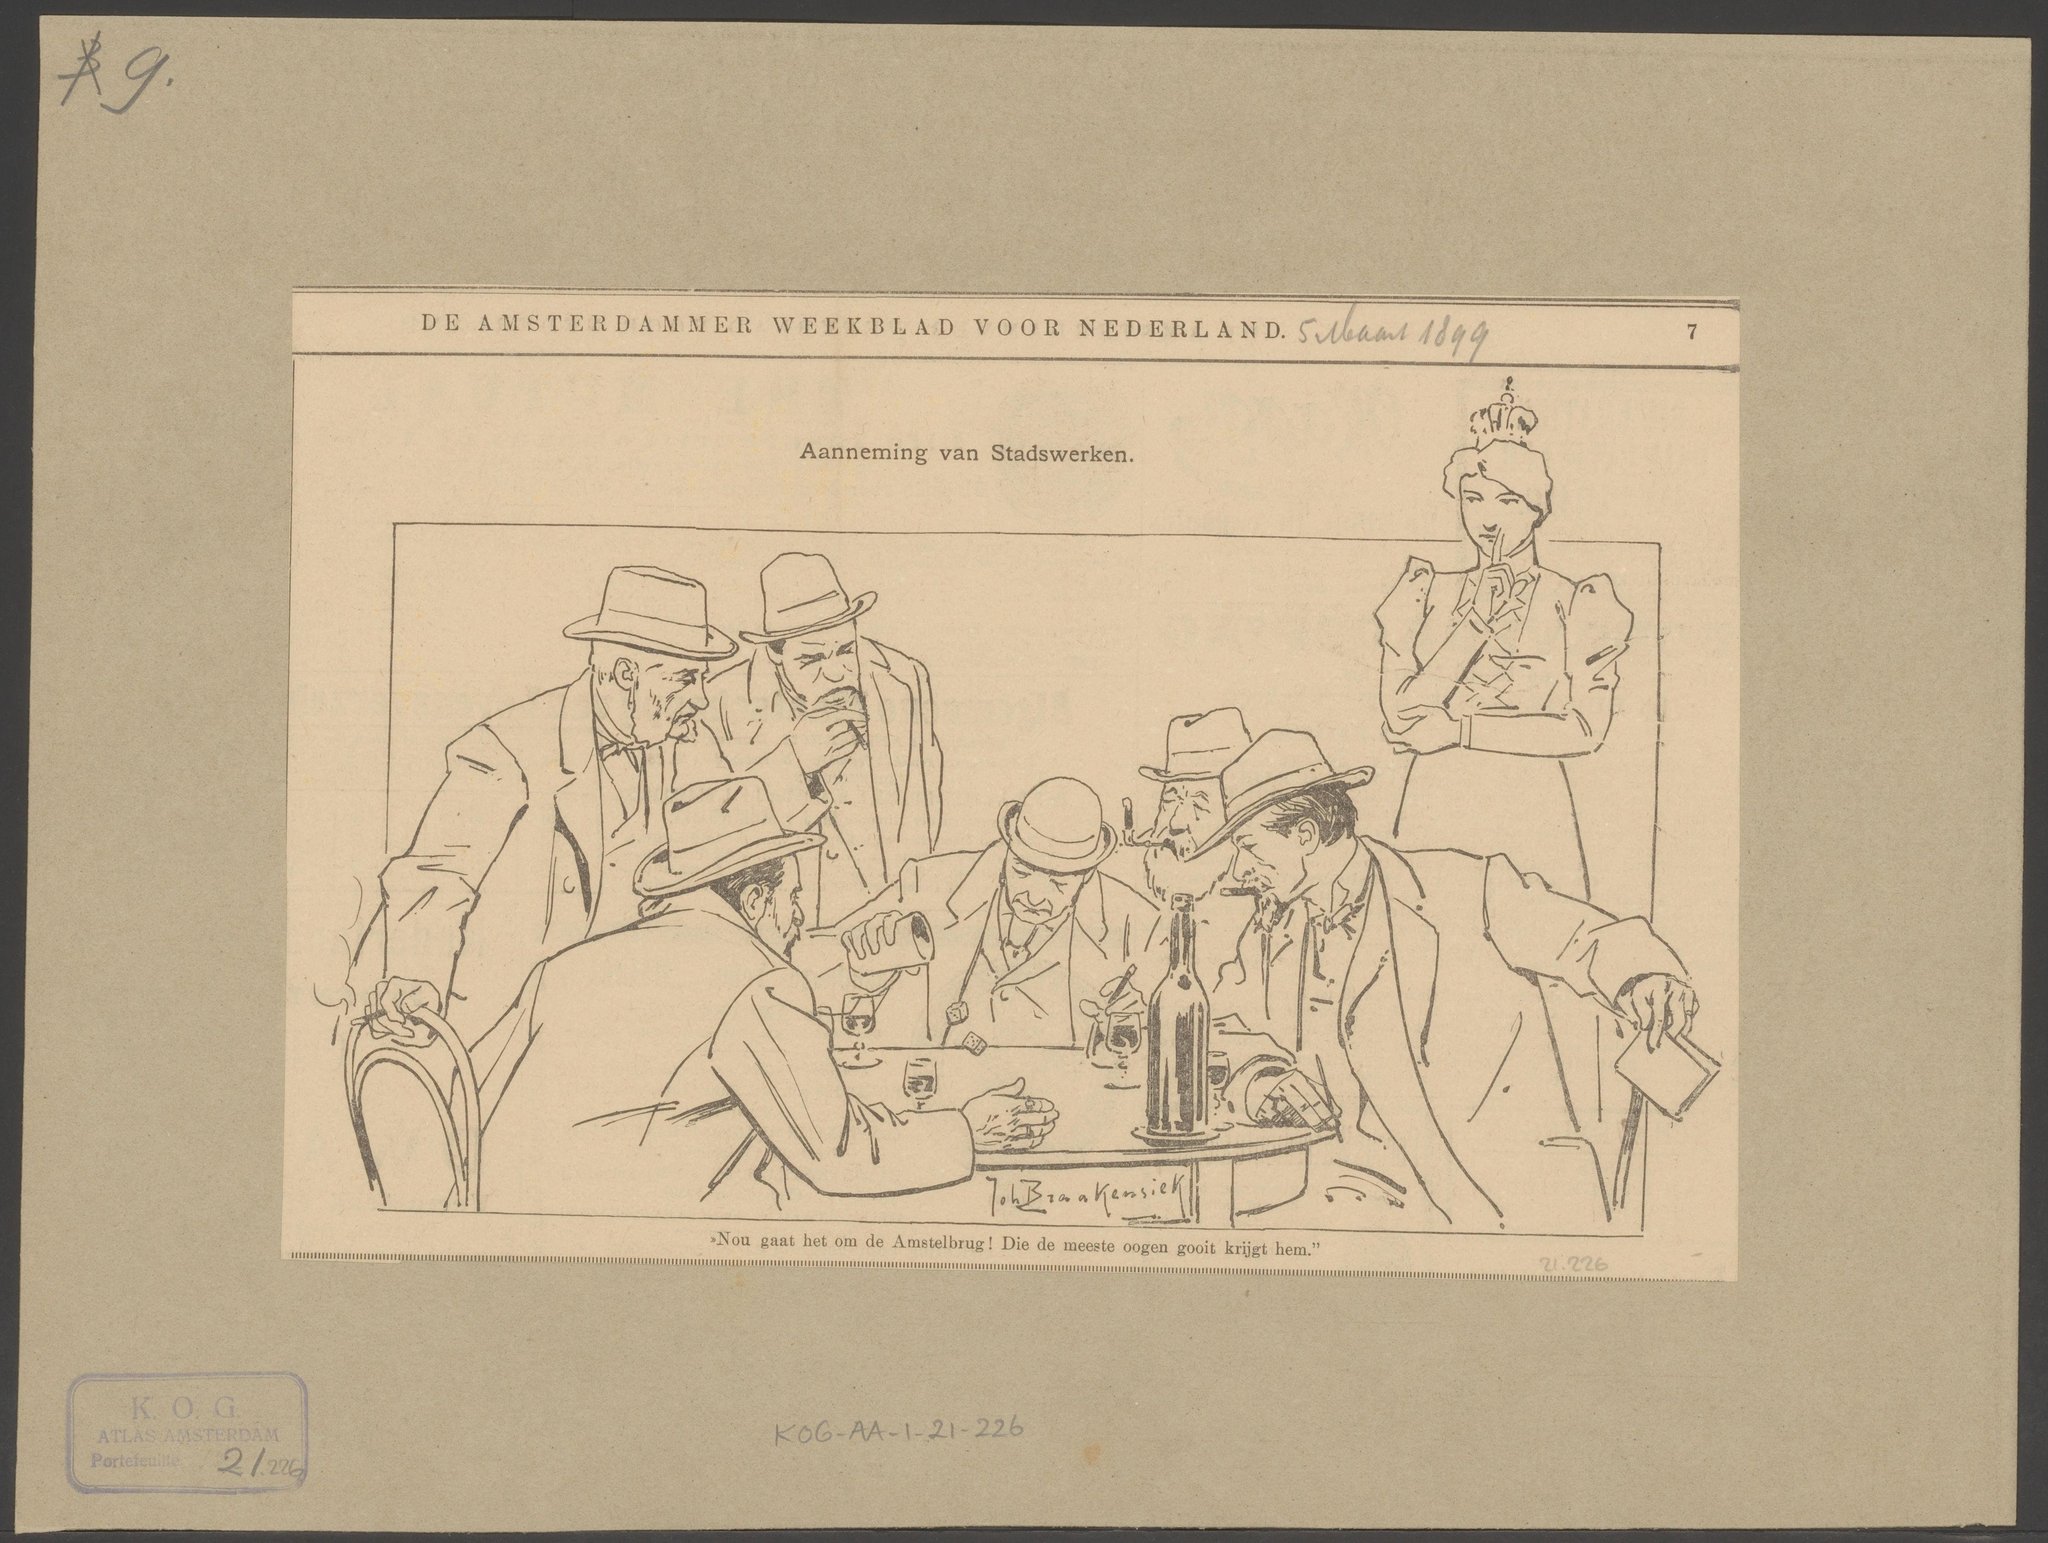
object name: cartoon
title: Aanneming van Stadswerken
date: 1899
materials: paper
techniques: letterpress printing, line block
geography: netherlands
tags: personification of a city, town-patron(ess), dice-games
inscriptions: collector's mark: Lugt 1641b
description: Onderwerpsrubriek binnen de Atlas Amsterdam: Bestrating, bruggen, wegen.